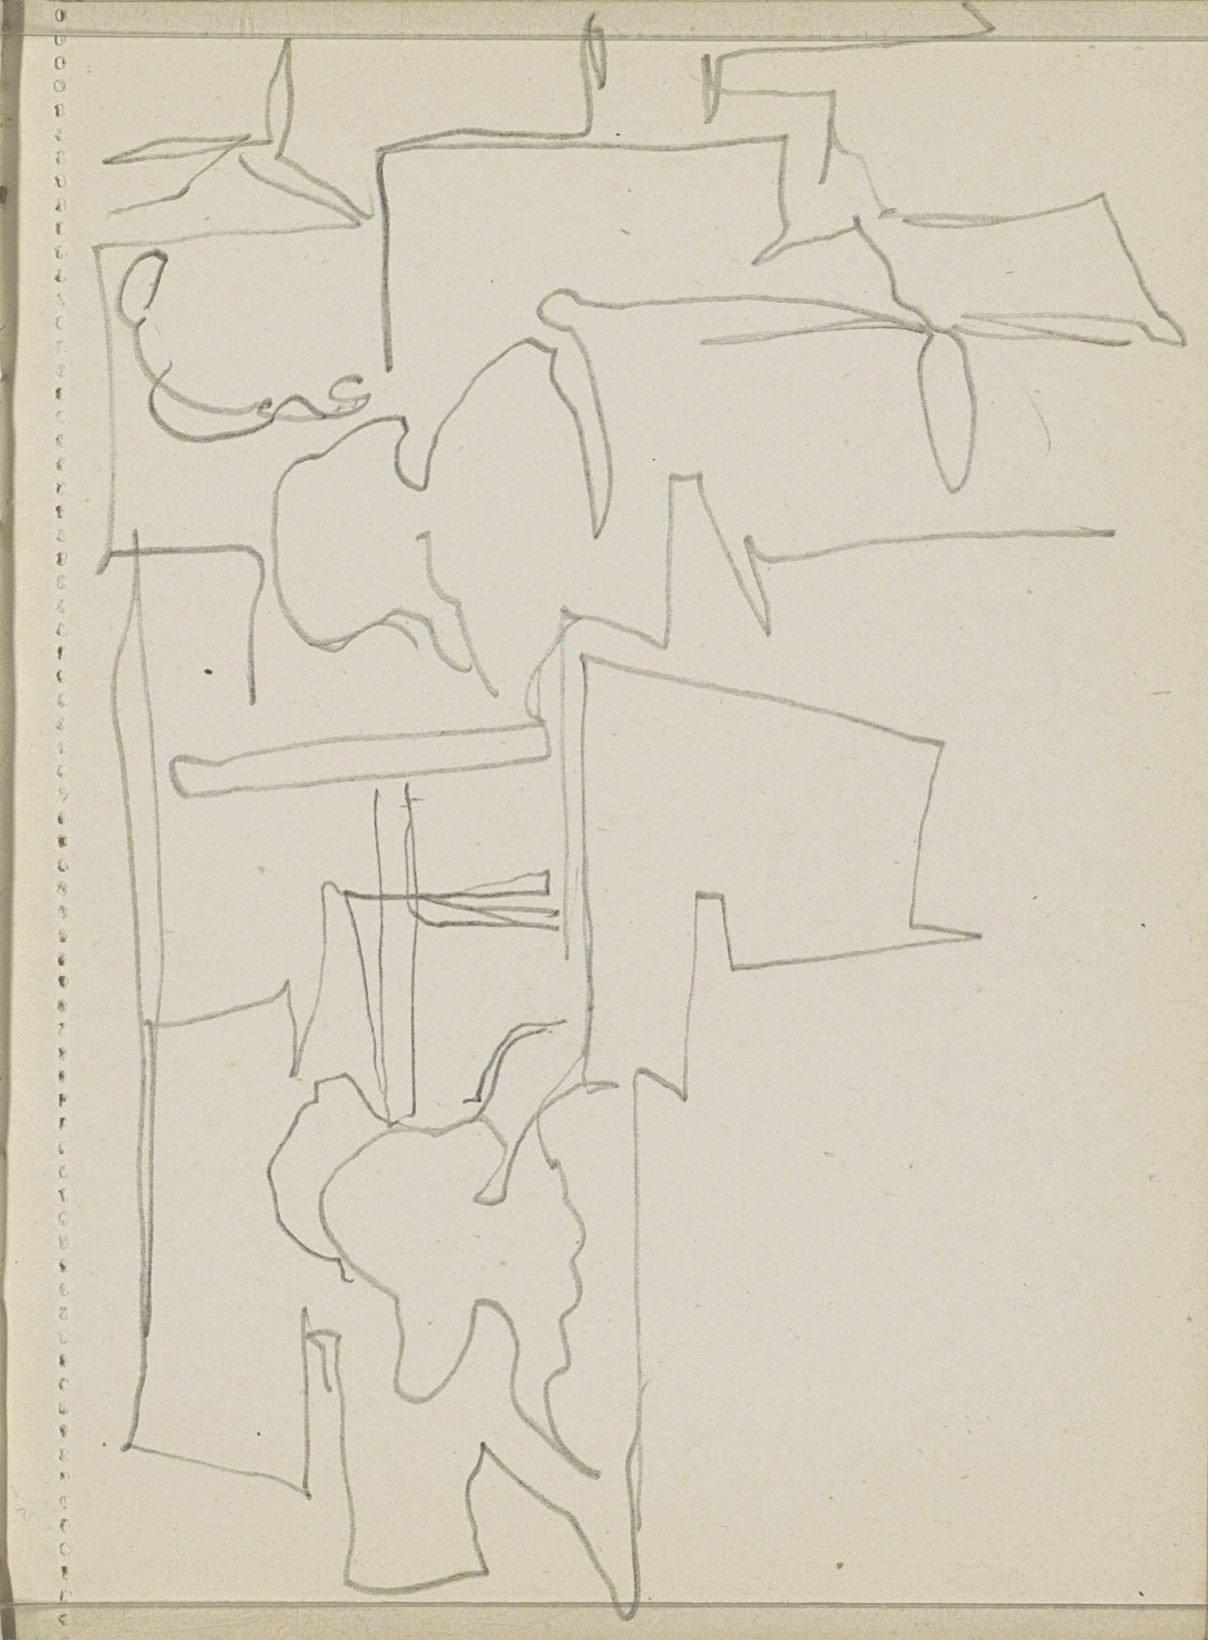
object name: sketchbook leaf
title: Figuren in het interieur van een café of restaurant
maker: reijer stolk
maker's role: draughtsman, print maker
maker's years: 1896-1945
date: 1906-1945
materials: paper, pencil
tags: inn, coffee-house, public house, etc.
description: De figuren zitten aan tafels. Blad 10 recto uit een schetsboek met 53 bladen.